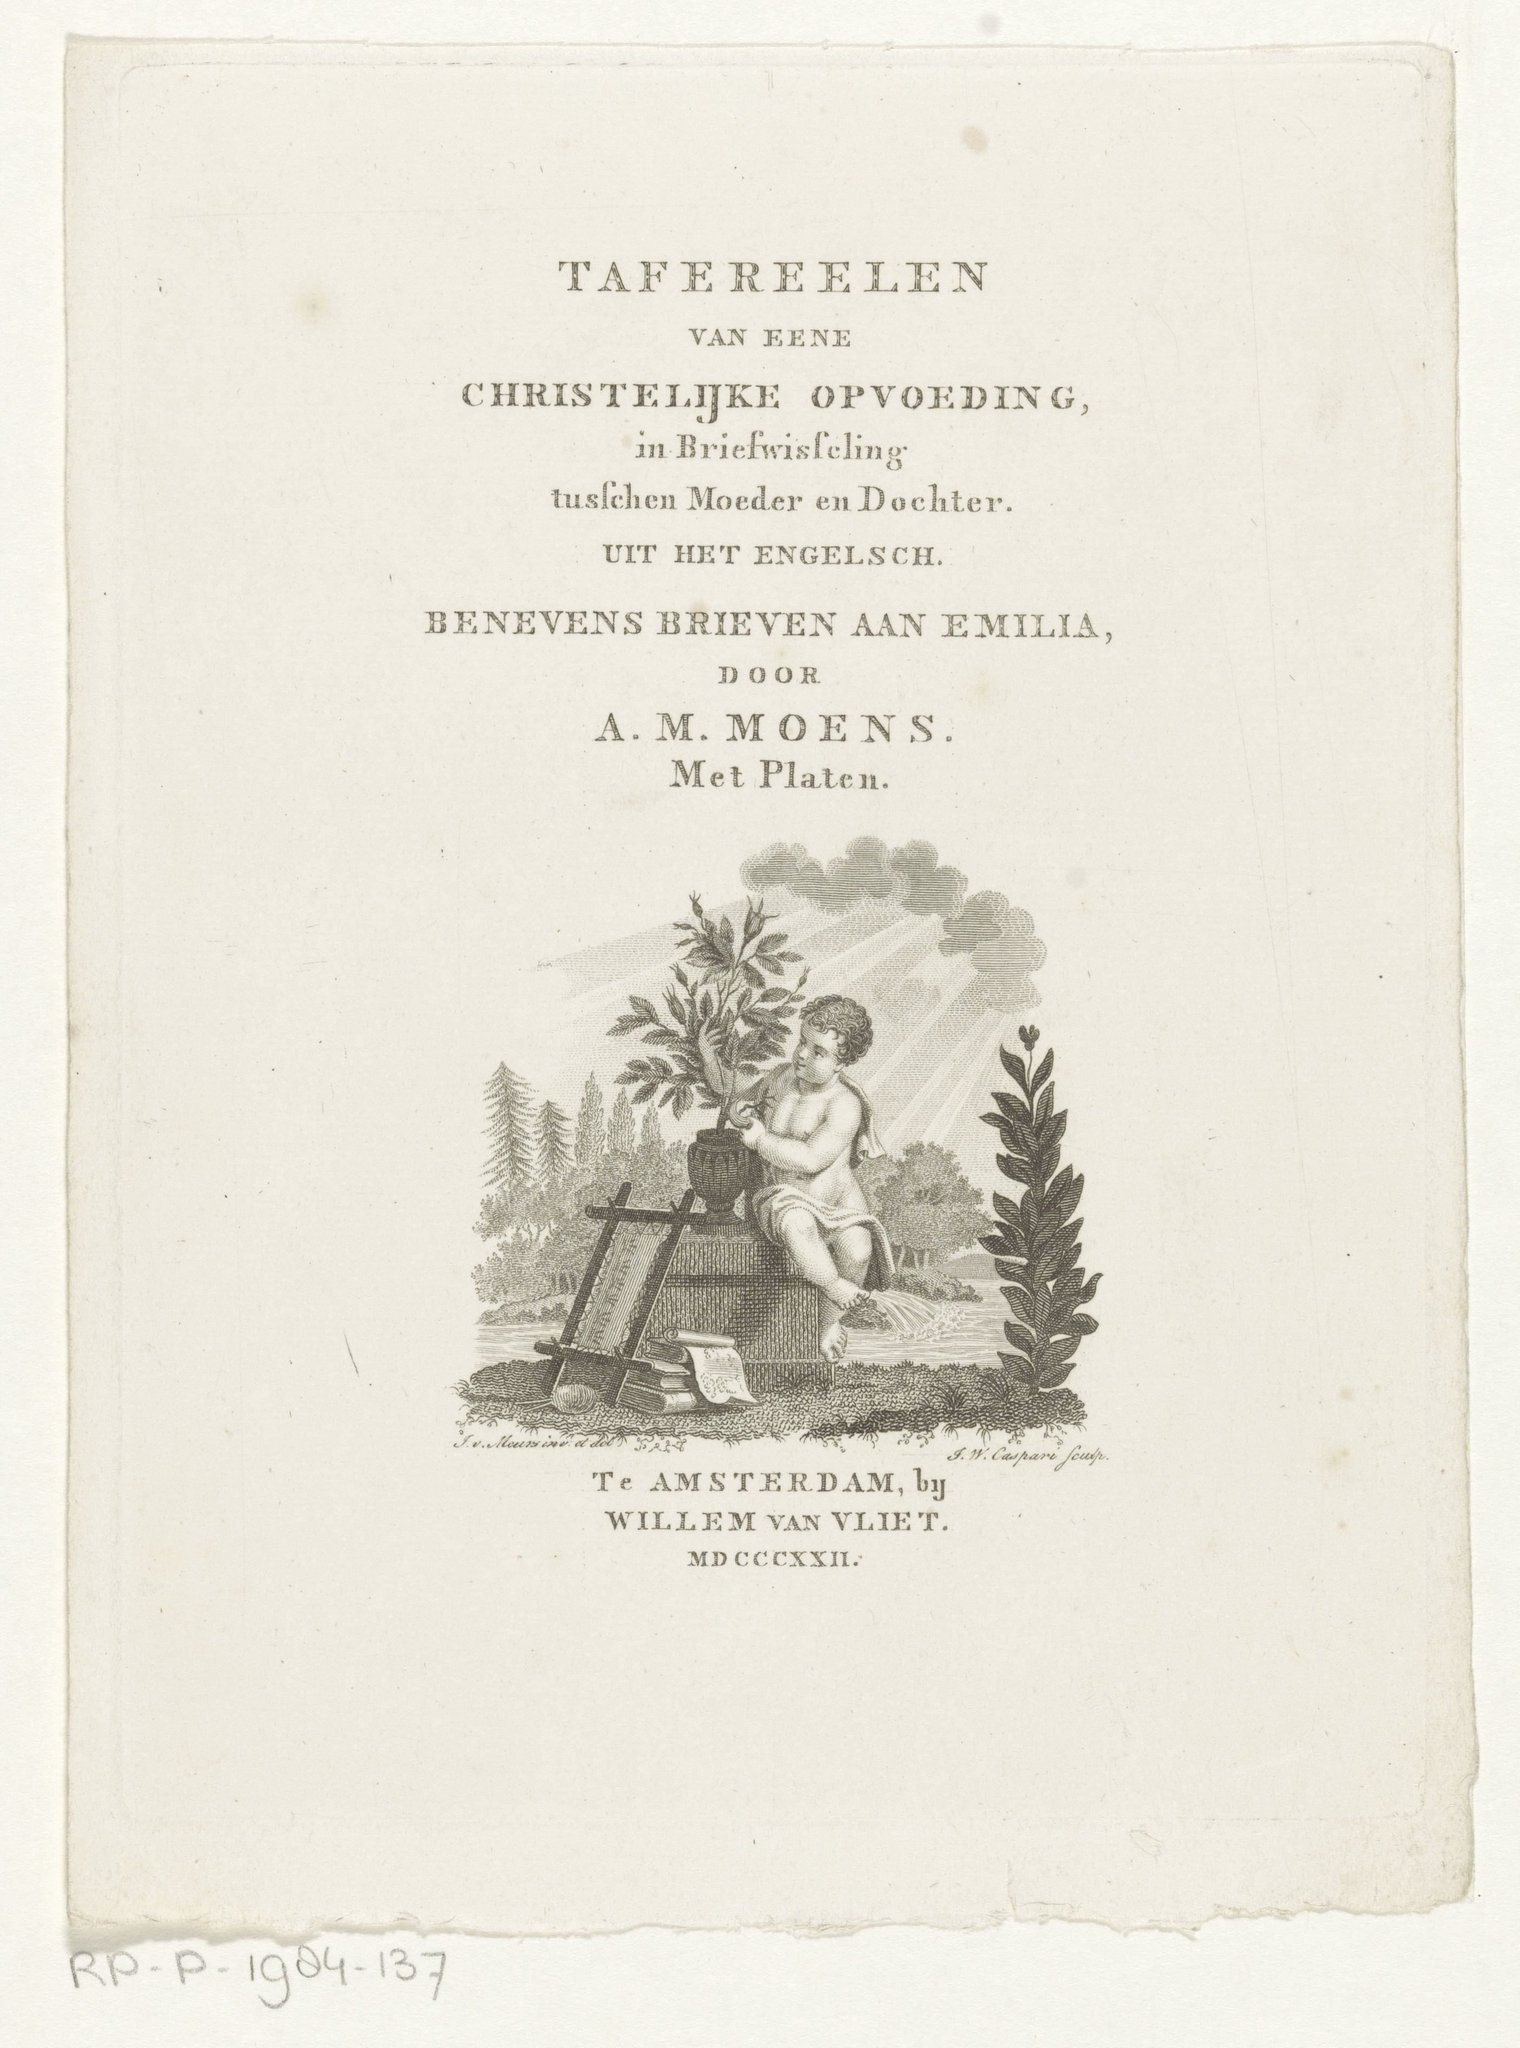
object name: titelblad, titelpagina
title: Jongen met sikkel naast rozenstruik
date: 1822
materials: paper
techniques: engraving, etching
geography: amsterdam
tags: boy (child between toddler and youth), shrubs: rose-bush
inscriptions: collector's mark: Lugt 2760, collector's mark: Lugt 2228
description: Titelpagina voor: Moens, A.M. Tafereelen van eene christelijke opvoeding, in Briefwisseling tusschen Moeder en Dochter. Amsterdam: Vliet, Willem van, 1822.